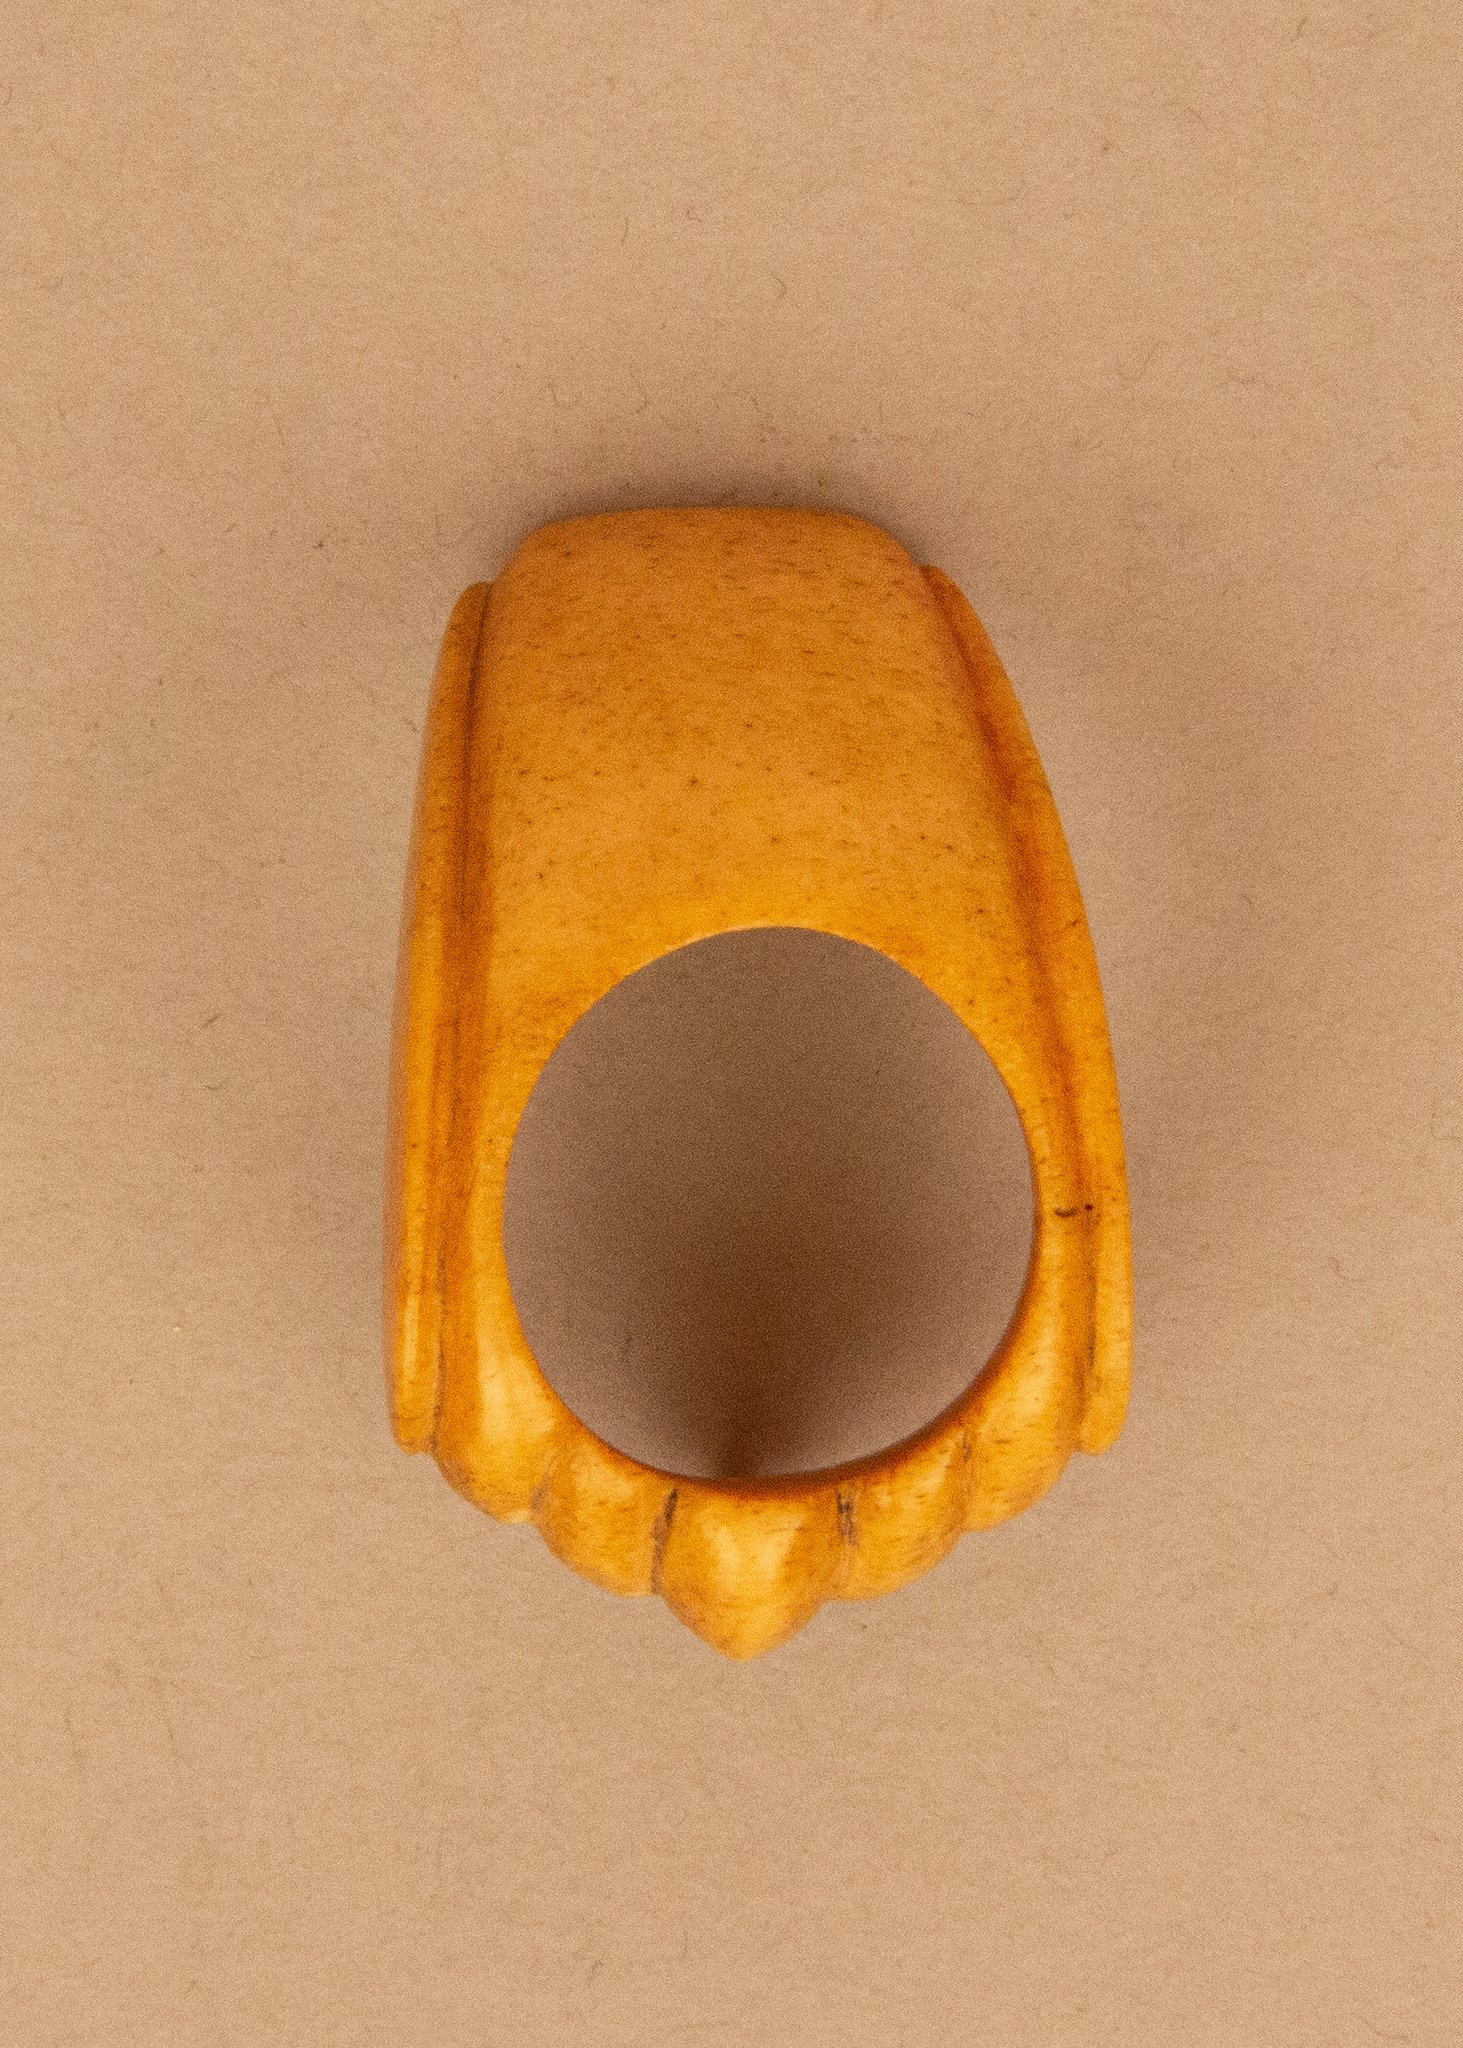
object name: ring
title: Archer's Thumb Ring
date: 1601-1700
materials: ivory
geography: india